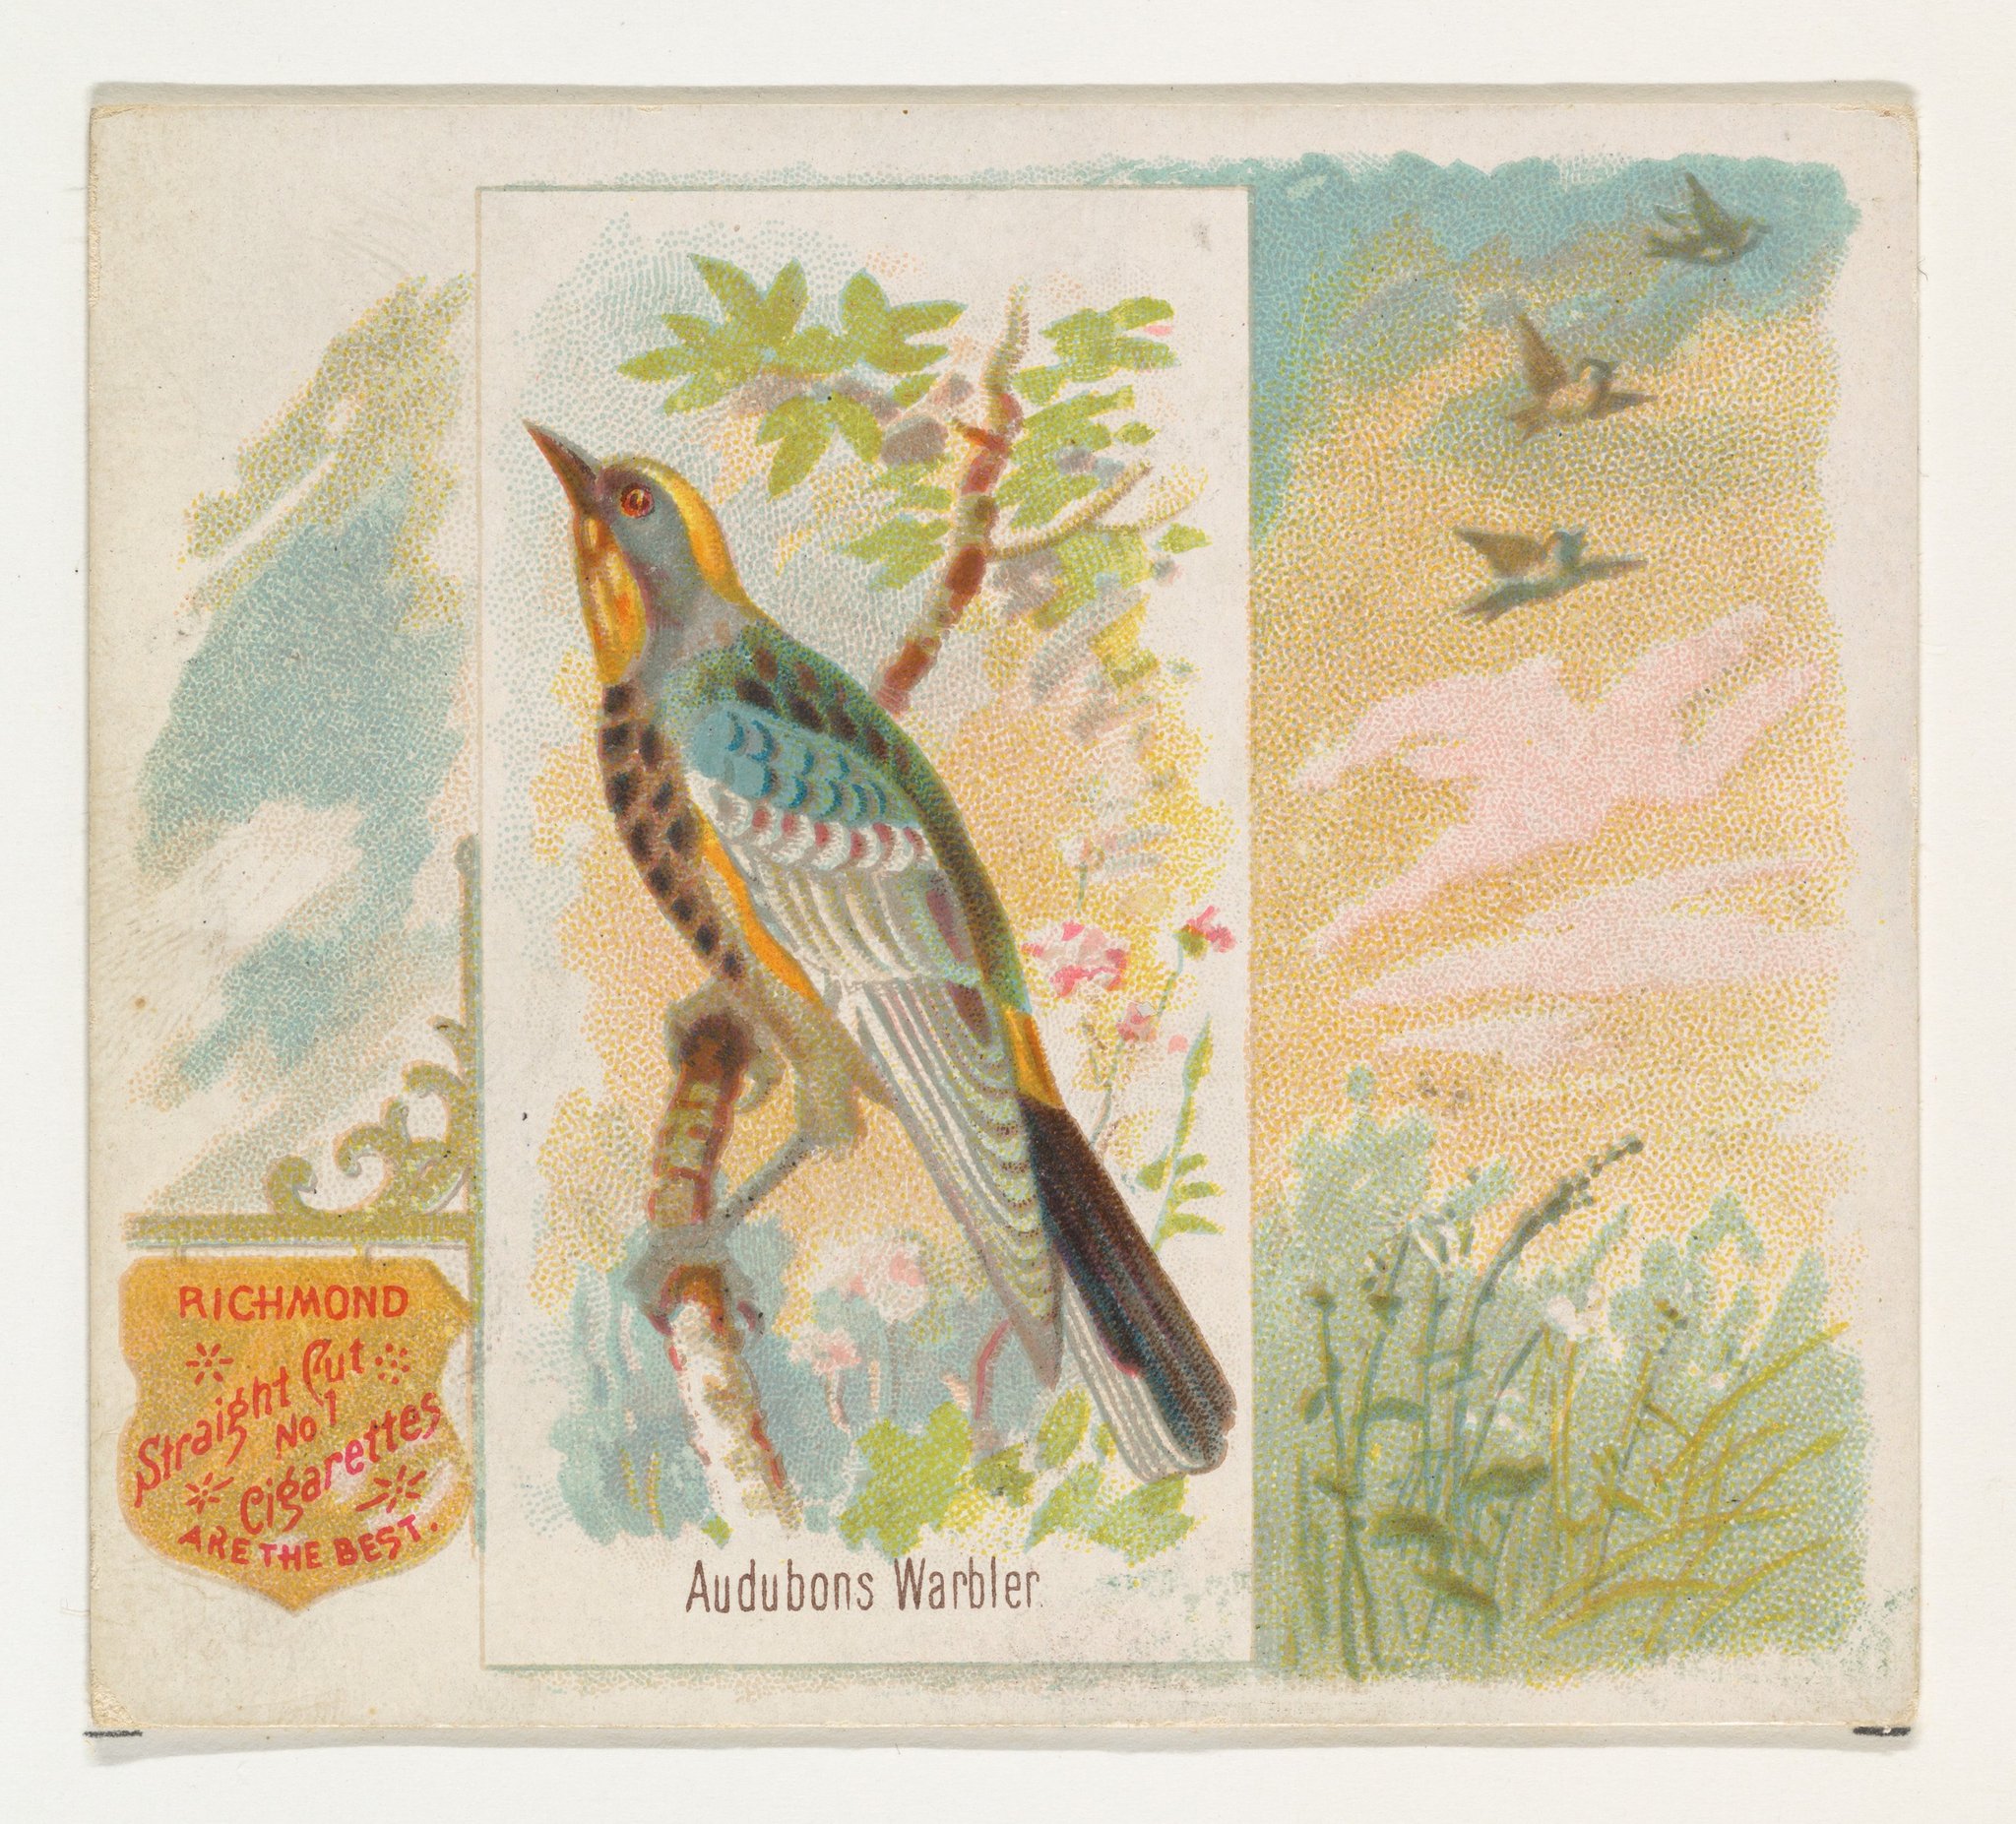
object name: print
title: Audobons Warbler, from the Song Birds of the World series (N42) for Allen & Ginter Cigarettes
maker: allen & ginter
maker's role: publisher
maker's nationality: american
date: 1890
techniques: color lithograph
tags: birds